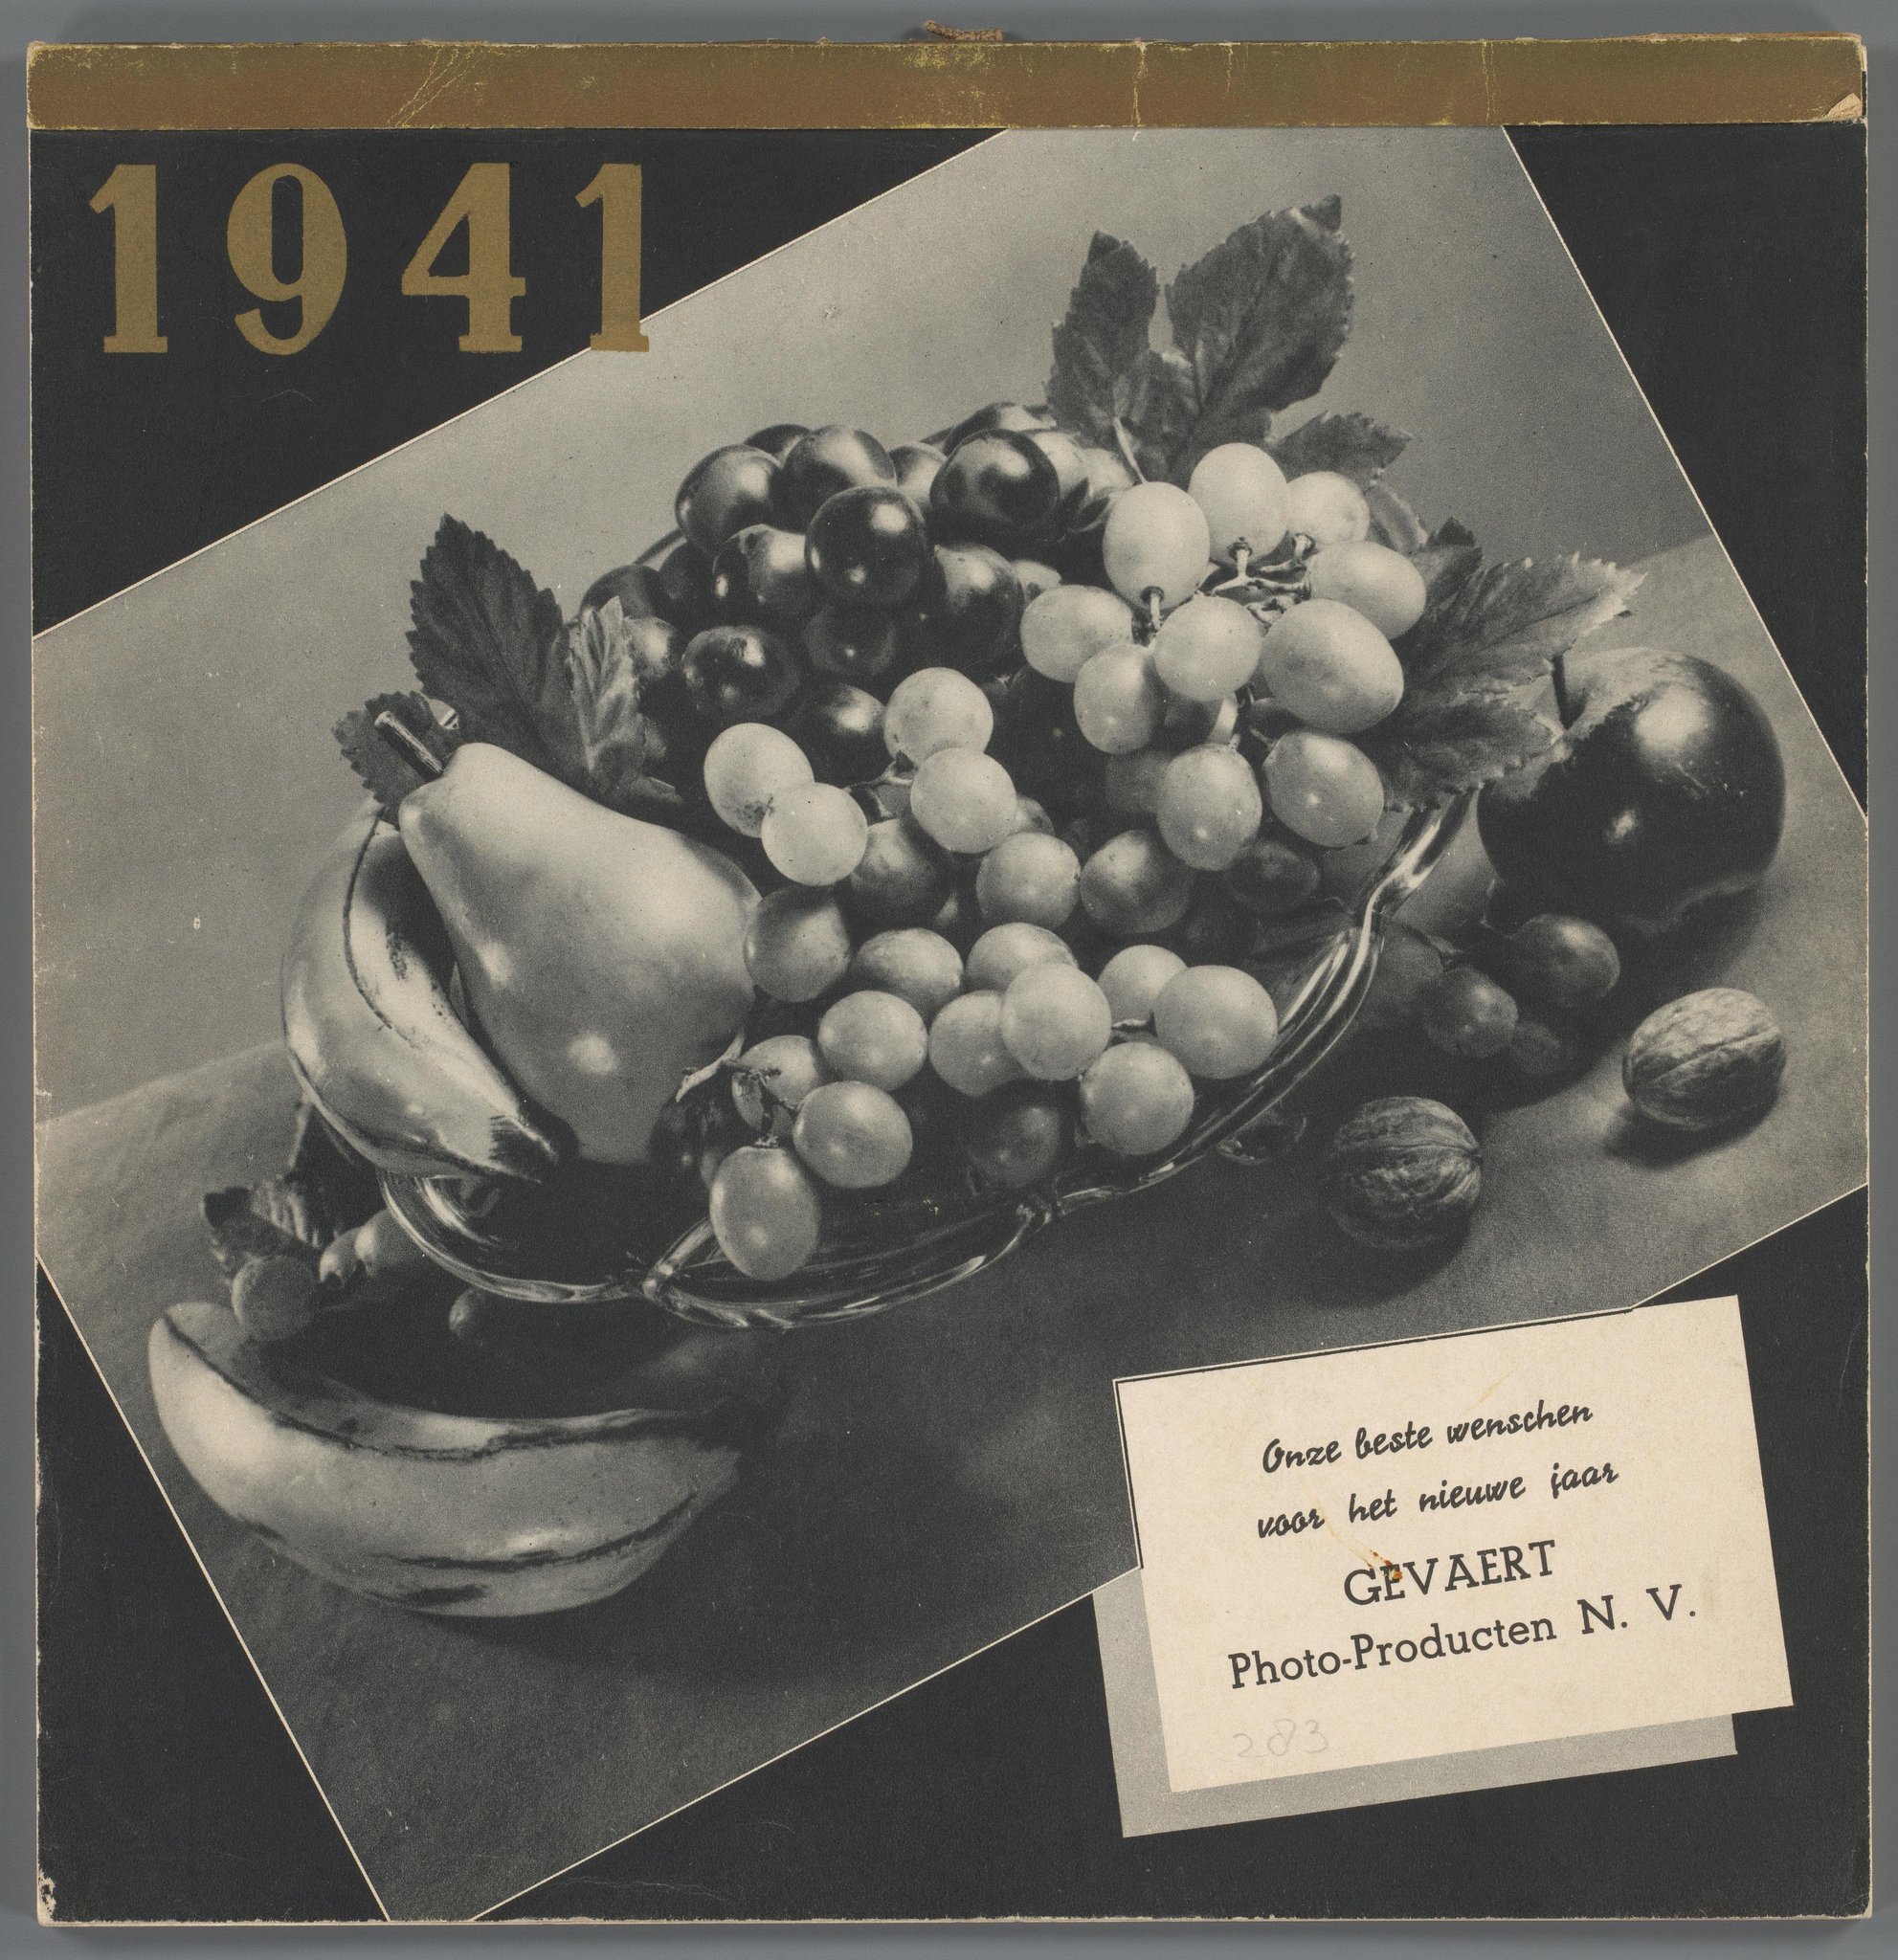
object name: photomechanical print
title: Kalender voor het jaar 1941 met 12 rotogravures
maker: Anonymous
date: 1941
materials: paper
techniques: rotogravure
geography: antwerp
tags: calendar, almanac